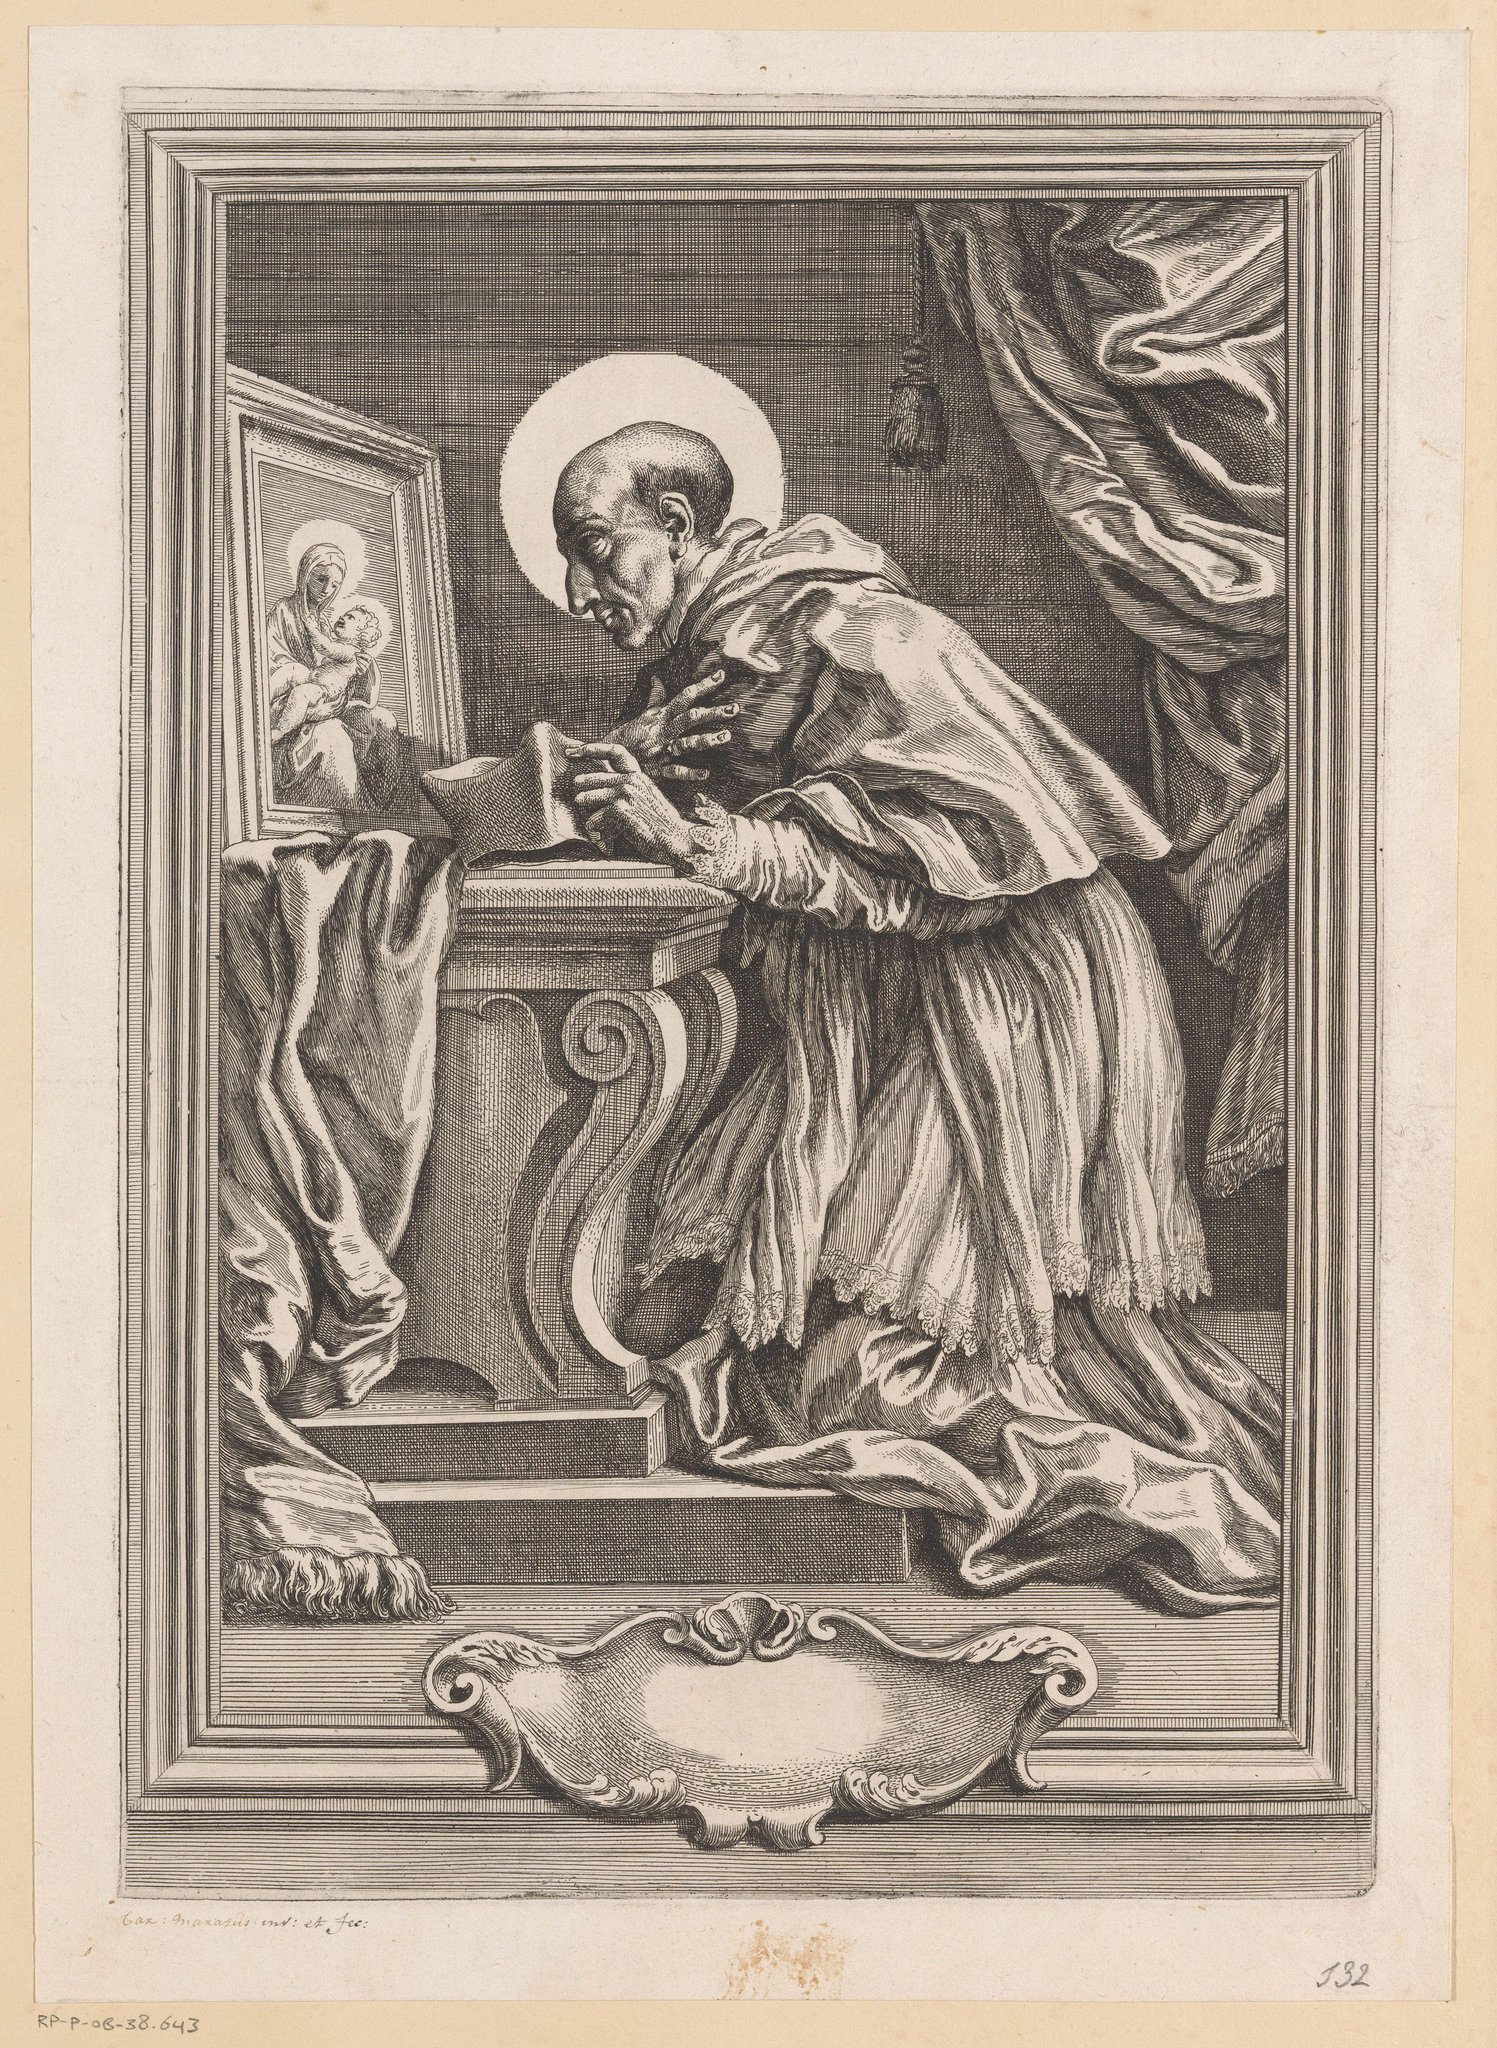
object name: print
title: Leven van de heilige Turibius de Mogrovejo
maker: Anonymous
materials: paper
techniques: etching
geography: italy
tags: priest, turibius de mogrovejo, archbishop, bishop, etc. (roman catholic)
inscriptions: collector's mark: Lugt 240, inscription: ‘Car: Maratus inv: et fec:’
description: De heilige Turibius de Mogrovejo, aartsbisschop van Lima, knielend voor een altaar met een beeltenis van Maria met Kind. Onderaan een lege cartouche.